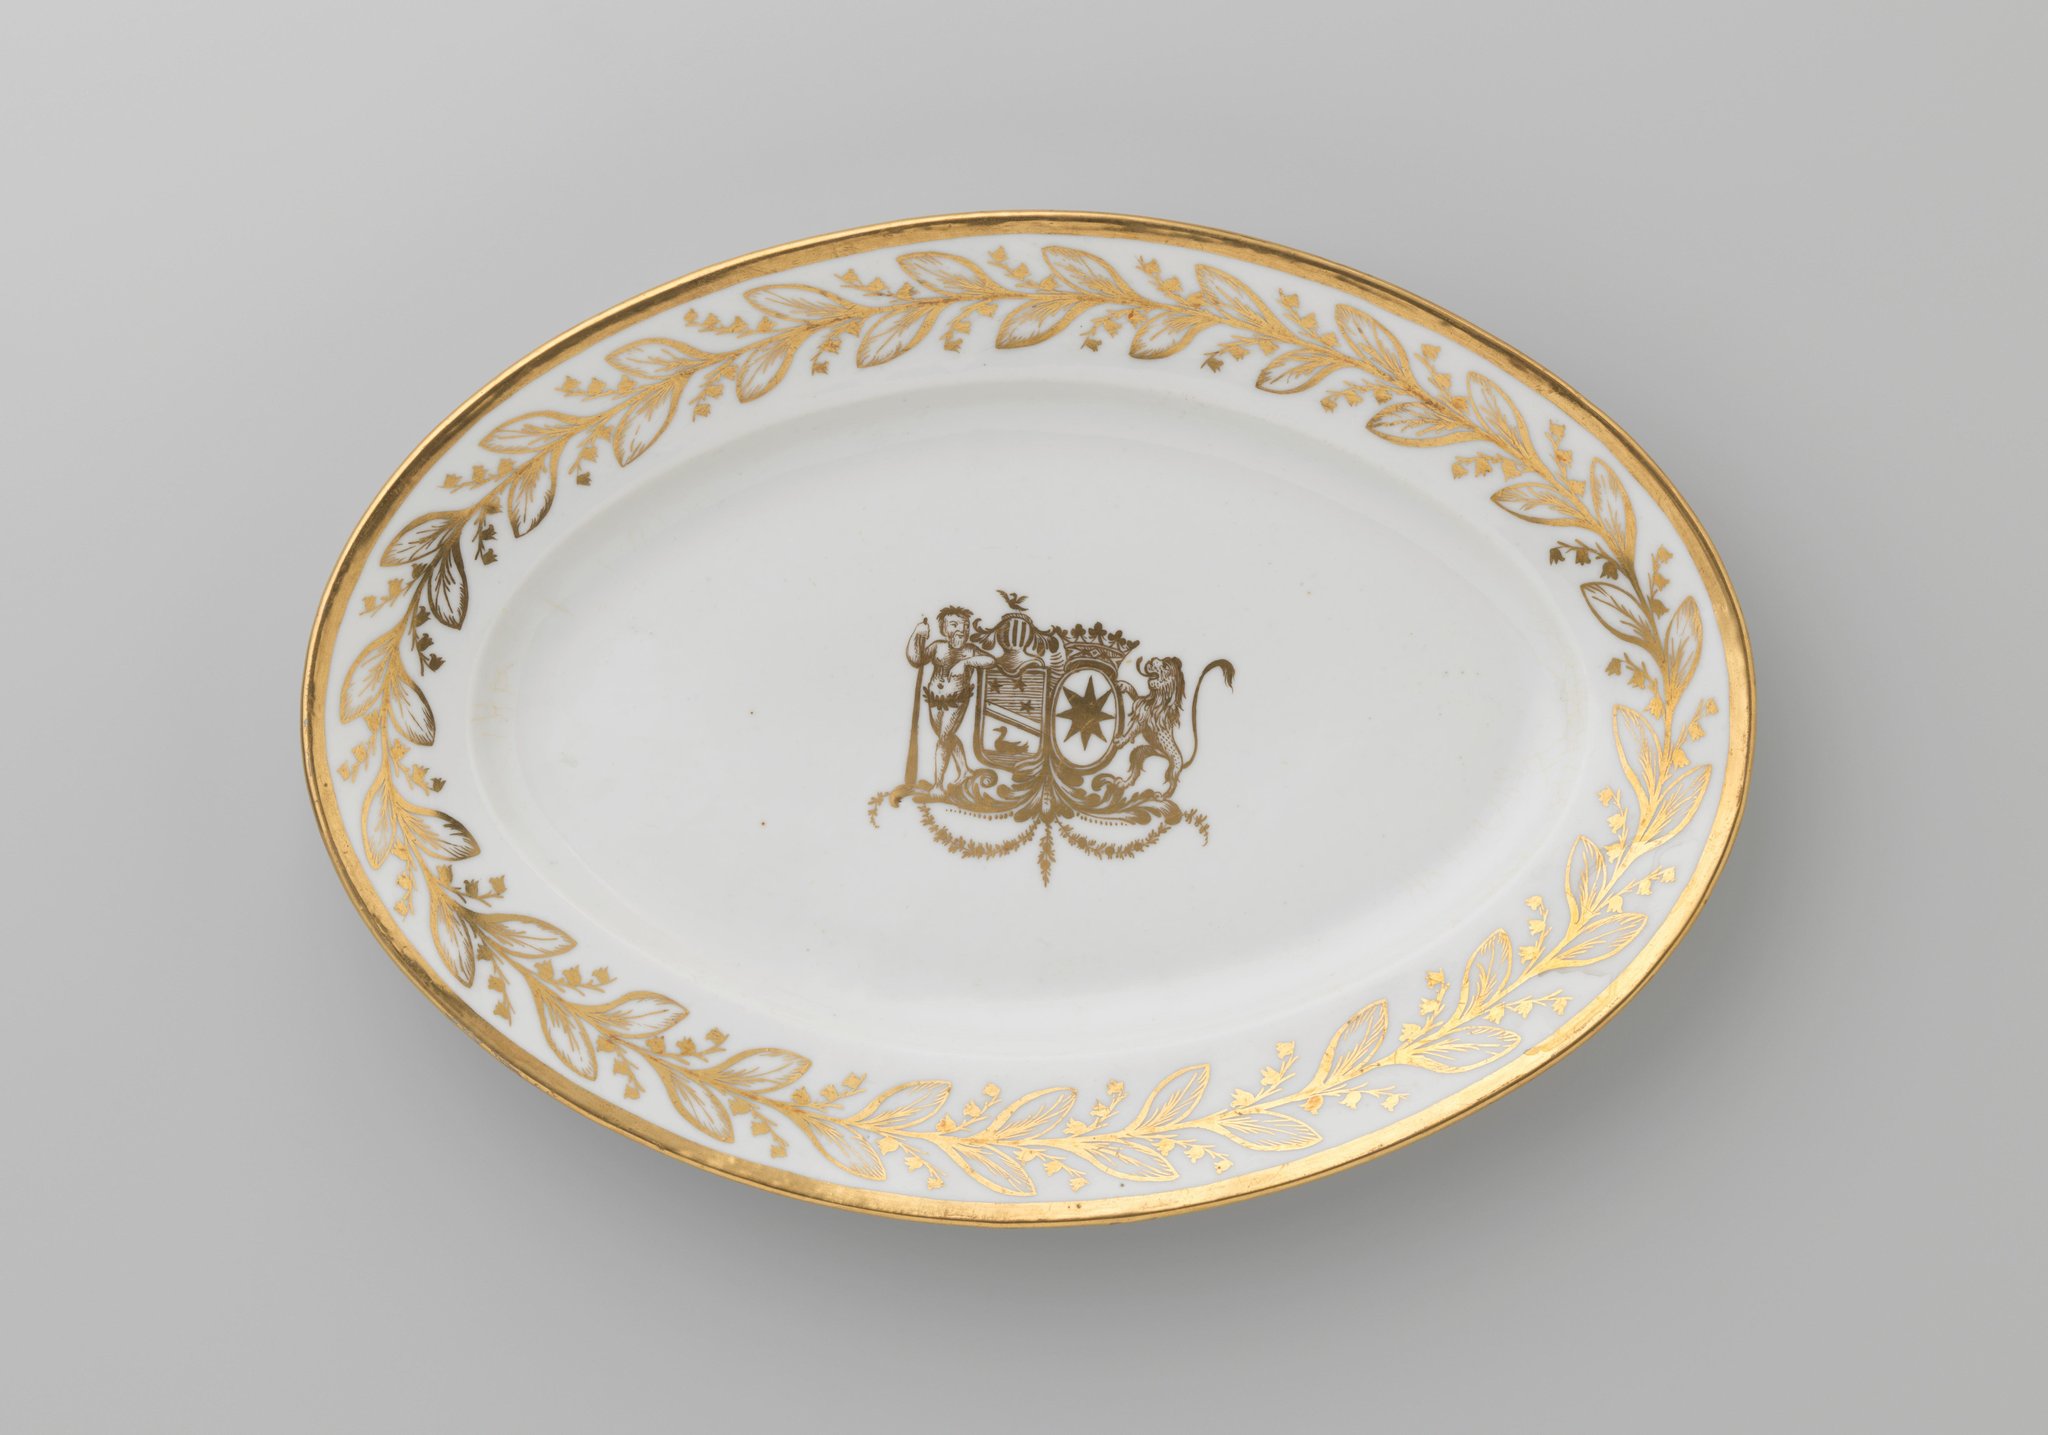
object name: service set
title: Dish with the coat of arms of Hendrik Peter Godfried Quack and Isabella Gertraud von Carnap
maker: Anonymous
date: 1790-1800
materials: glaze, gold, paint, porcelain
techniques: firing, forming, gilding, turning, vitrification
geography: netherlands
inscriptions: mark: ‘B.L.’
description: Ovale schotel van porselein, beschilderd op het glazuur met goud. Op het plat het alliantiewapen van Hendrik Peter Godfried Quack en Isabella Gertraud von Carnap. De rand met een bloemrank en een gouden band. Dubbele voetring.